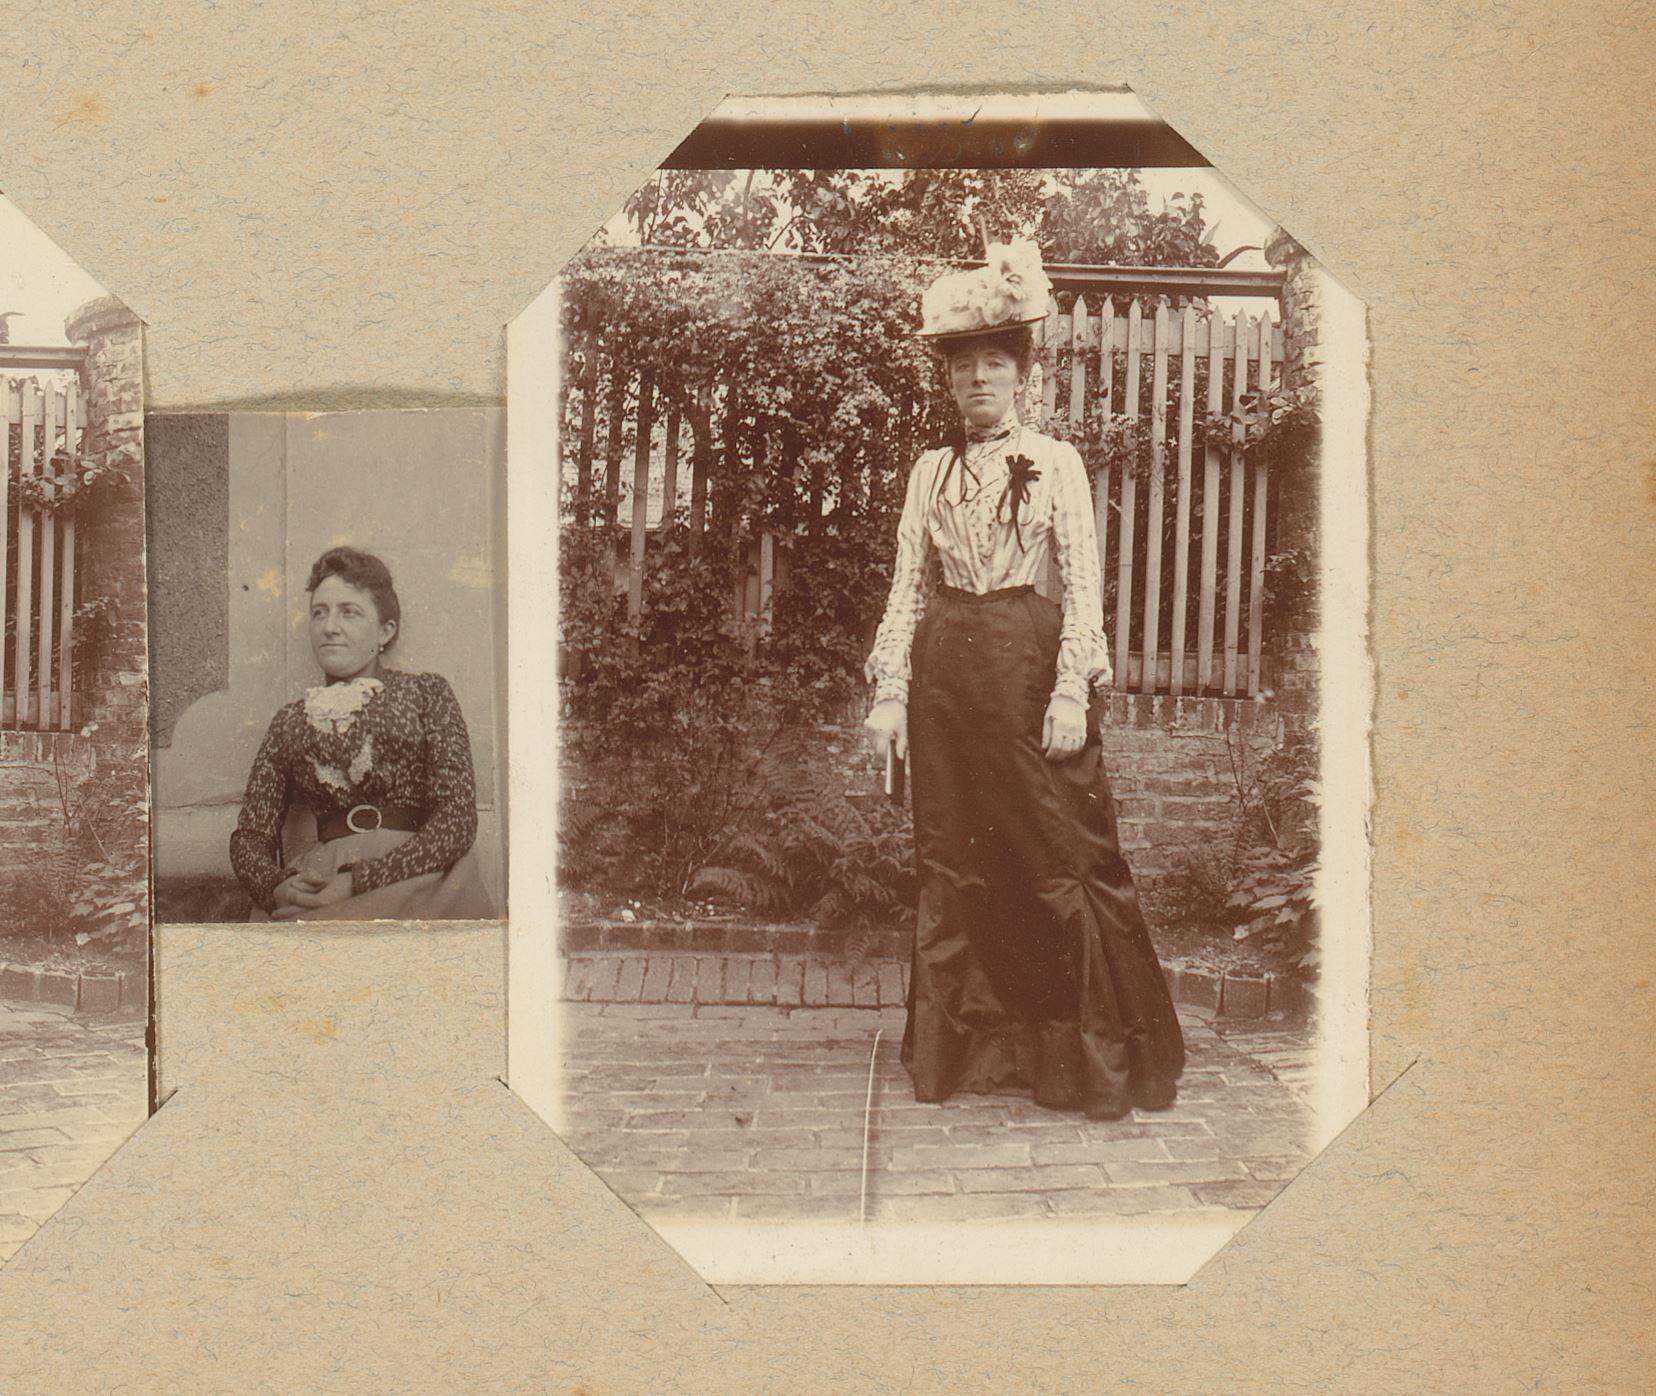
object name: album leaf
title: Portret van een staande vrouw in een tuin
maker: Anonymous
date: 1897-1900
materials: paper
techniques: gelatin silver print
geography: france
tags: adult woman, historical persons, france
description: Over de foto is een ander negatief afgedrukt van een voorstelling van bomen.